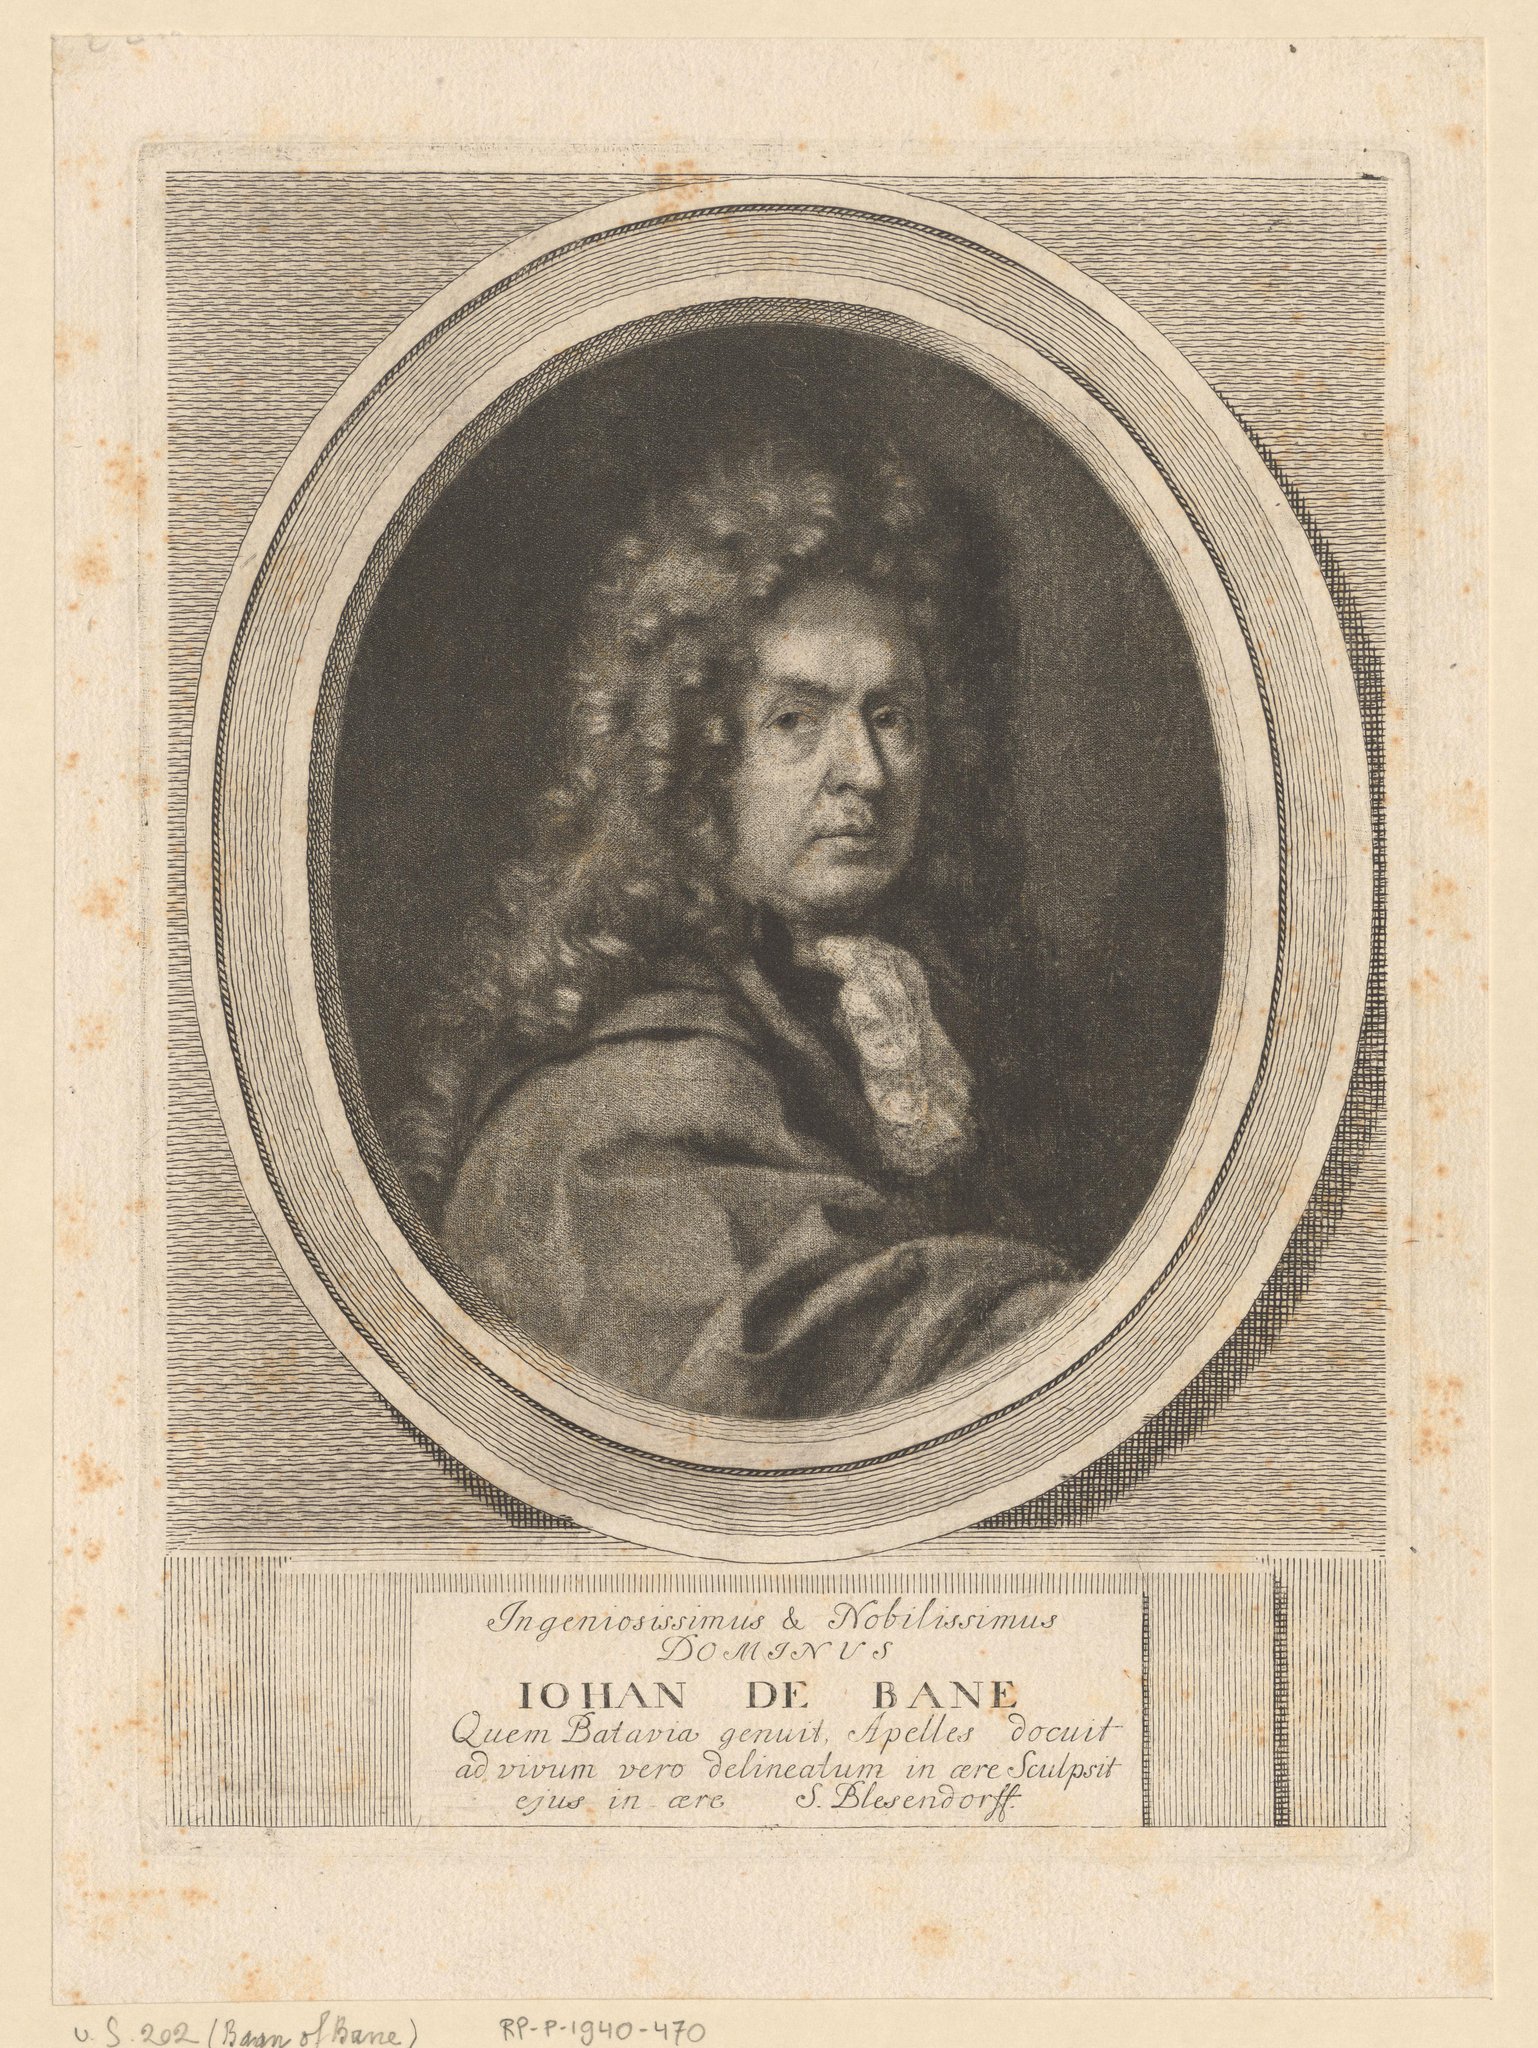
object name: print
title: Portret van Jan de Baen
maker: samuel blesendorf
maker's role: painter, print maker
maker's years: 1633-1706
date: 1643-1706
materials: paper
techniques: engraving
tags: haarlem, print maker, draughtsman, jan de baen, historical persons, portrait, self-portrait of artist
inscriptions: collector's mark: Lugt 2760, collector's mark: Lugt 2228